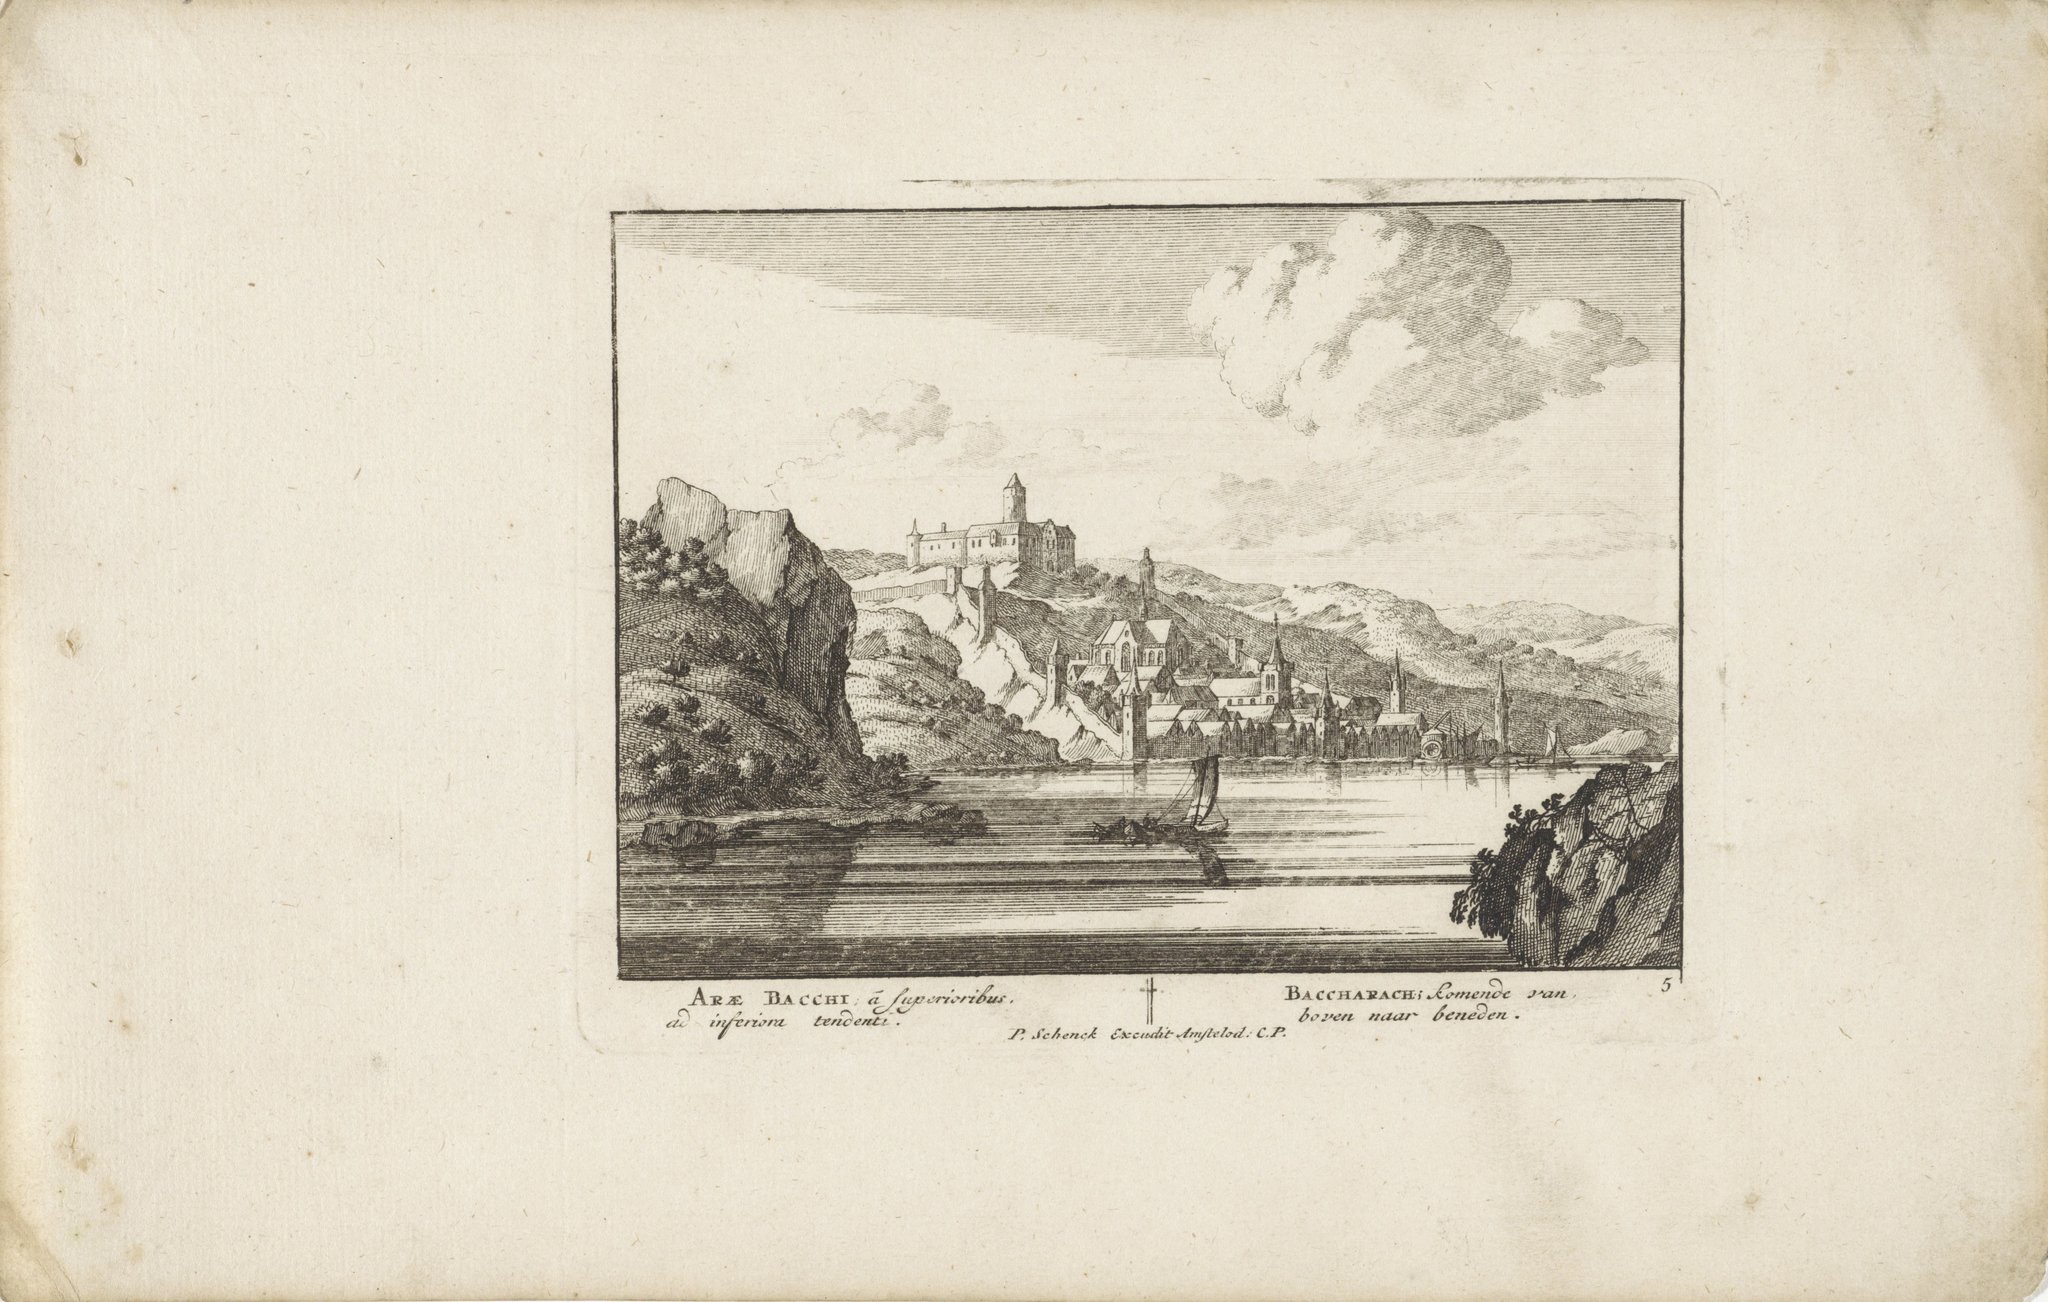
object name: print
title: Admirandorum quadruplex spectaculum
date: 1694-1697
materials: paper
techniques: etching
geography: amsterdam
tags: castle, river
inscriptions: collector's mark: Lugt 2228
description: Gezicht op de stad Bacharach aan de Rijn. Op de heuvel de burcht Stahleck. Op de voorgrond een zeilschip. Prent uit een serie van 71 prenten met Rijnlandschappen, gezichten op vorstelijke paleizen en stadsgezichten uit Den Haag en Amsterdam.